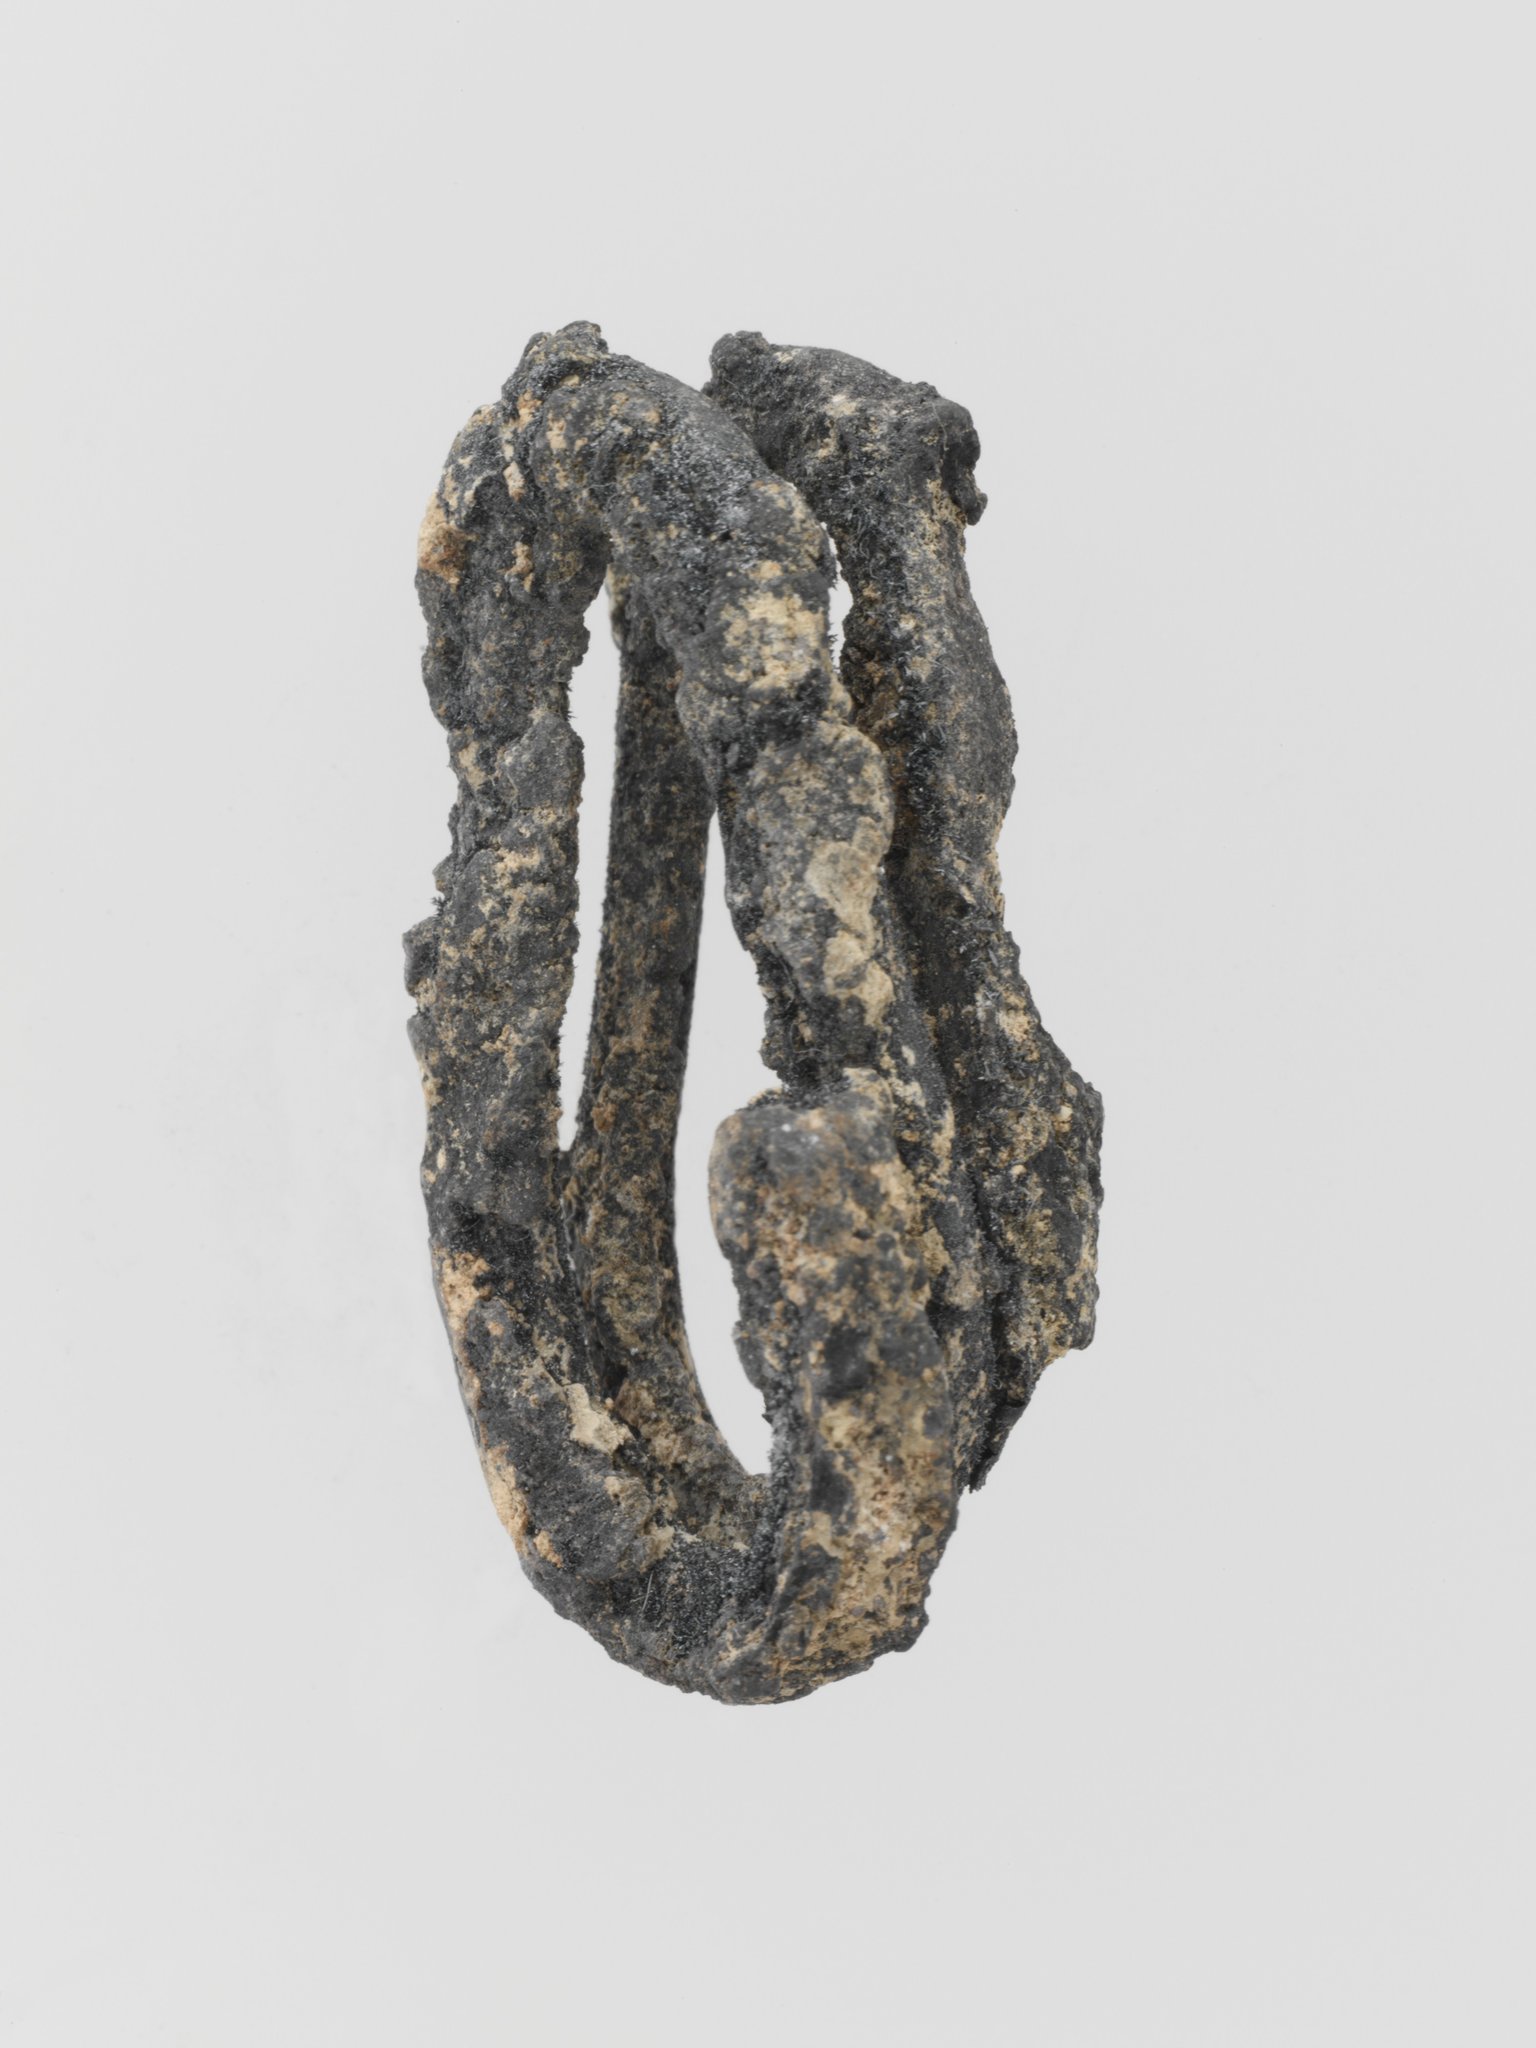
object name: earring or spiral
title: Silver spiral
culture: cypriot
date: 1600-1050 BCE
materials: silver